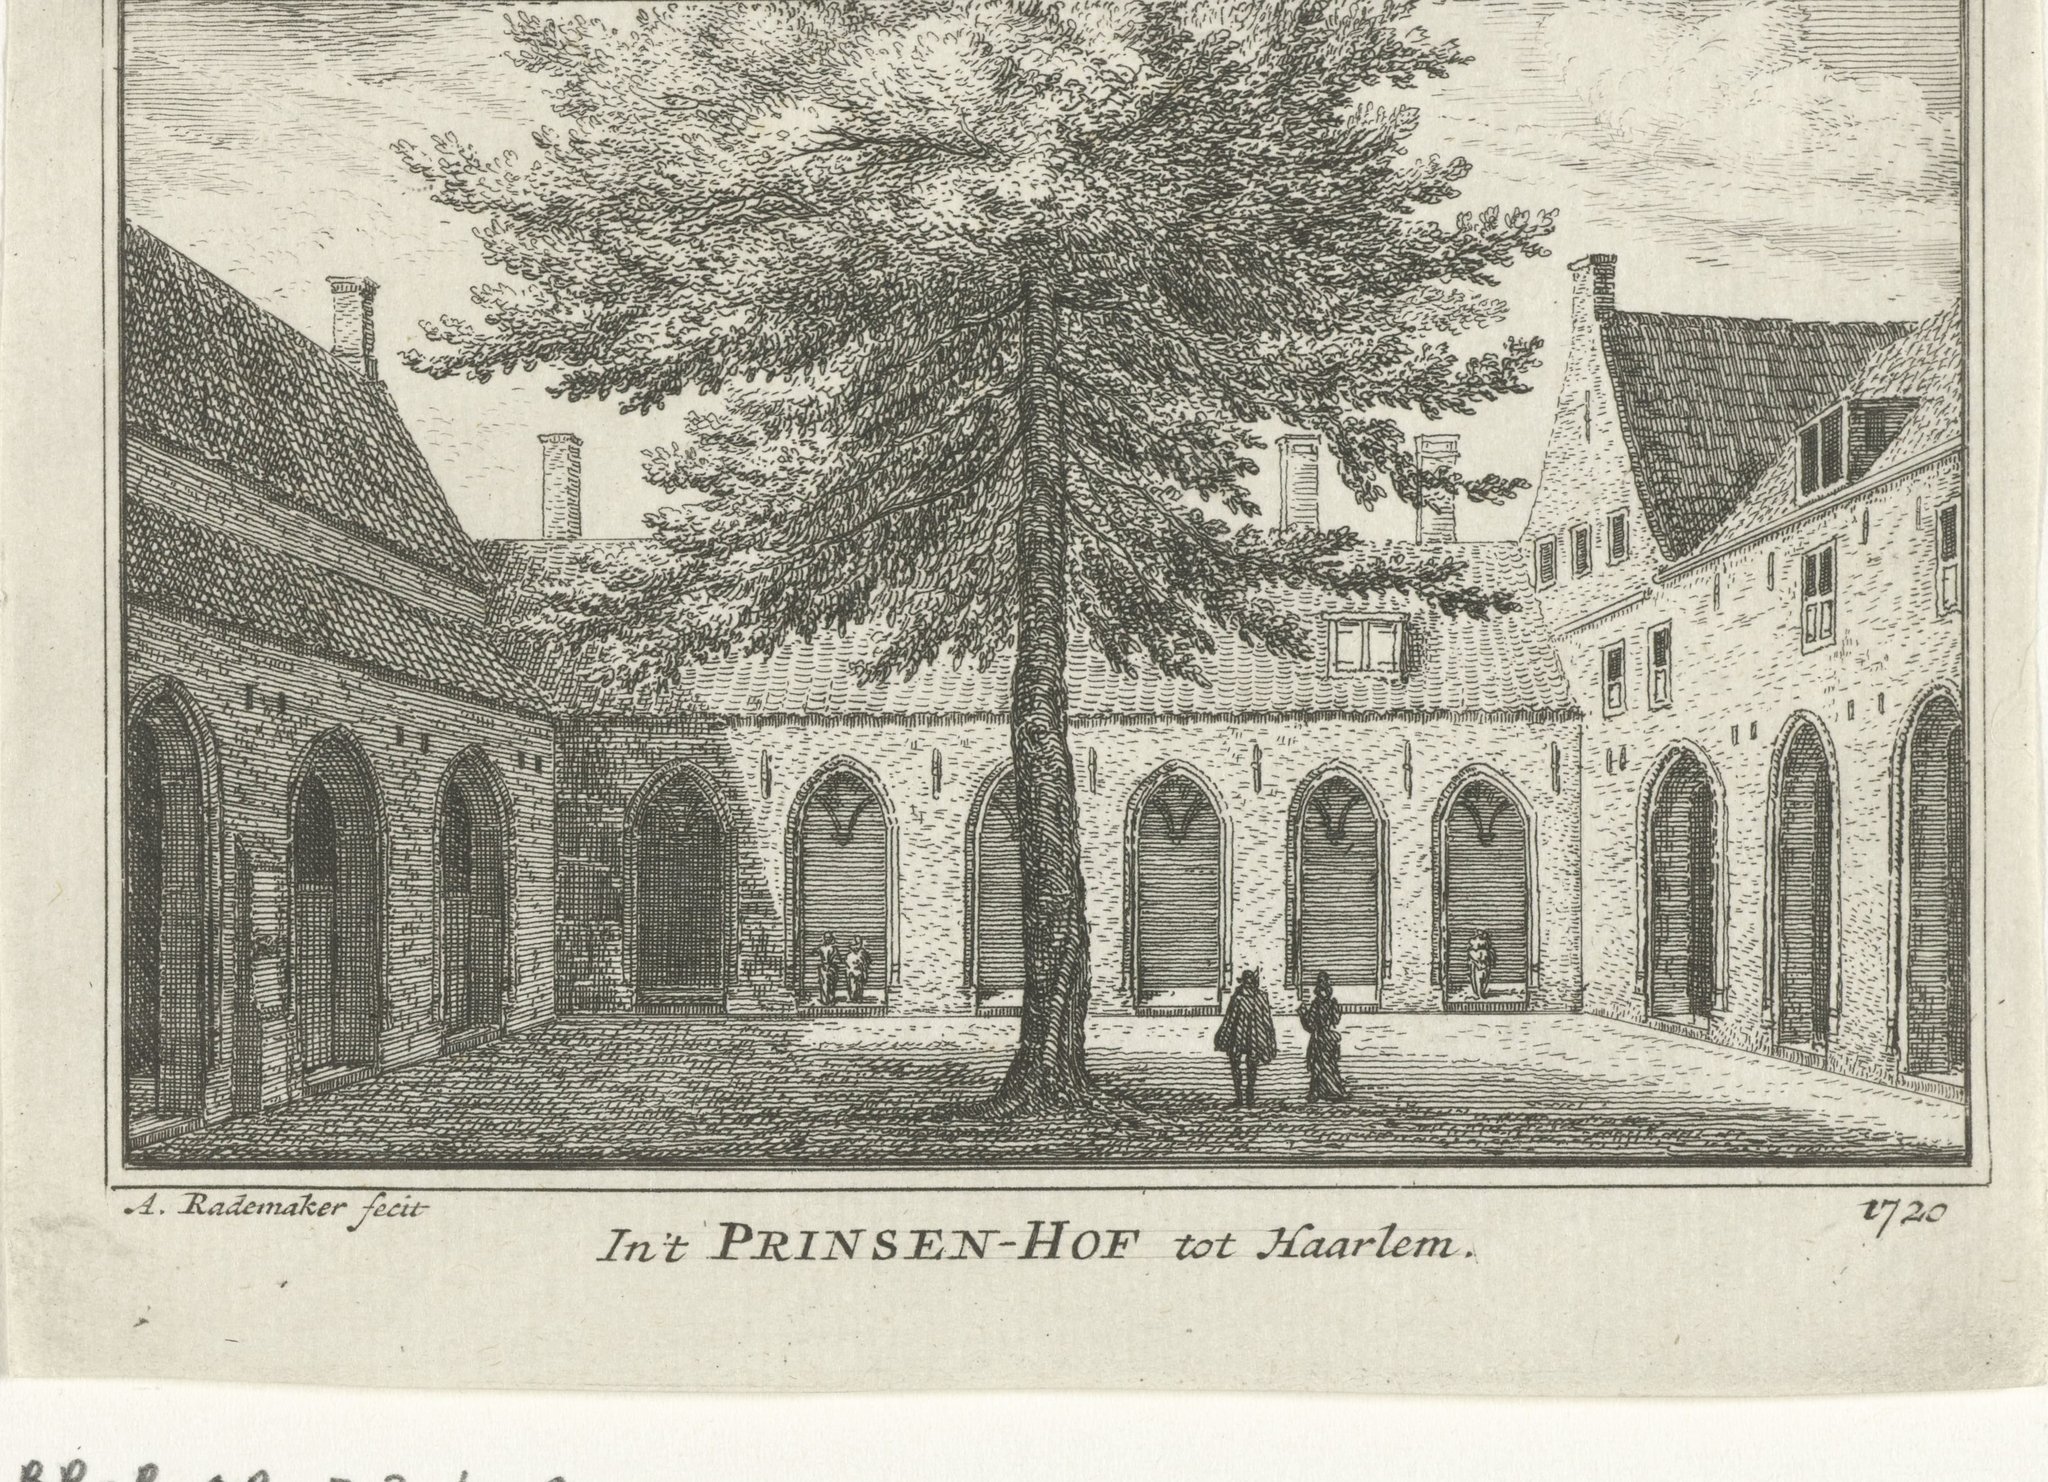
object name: print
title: Gezicht op de binnenplaats van het Prinsenhof te Haarlem, 1720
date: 1727-1733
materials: paper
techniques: etching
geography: amsterdam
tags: courtyard, haarlem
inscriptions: collector's mark: Lugt 2228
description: Illustratie uit: Abraham Rademaker, Matthaeus Brouërius van Niedek, Isaac Le Long, Kabinet van Nederlandsche en Kleefsche outheden en (...) voorname stads- en landgebouwen, Willem Barents en Antoni Schoonenburg: Amsterdam, 1727-1733, ill. nr. 66.